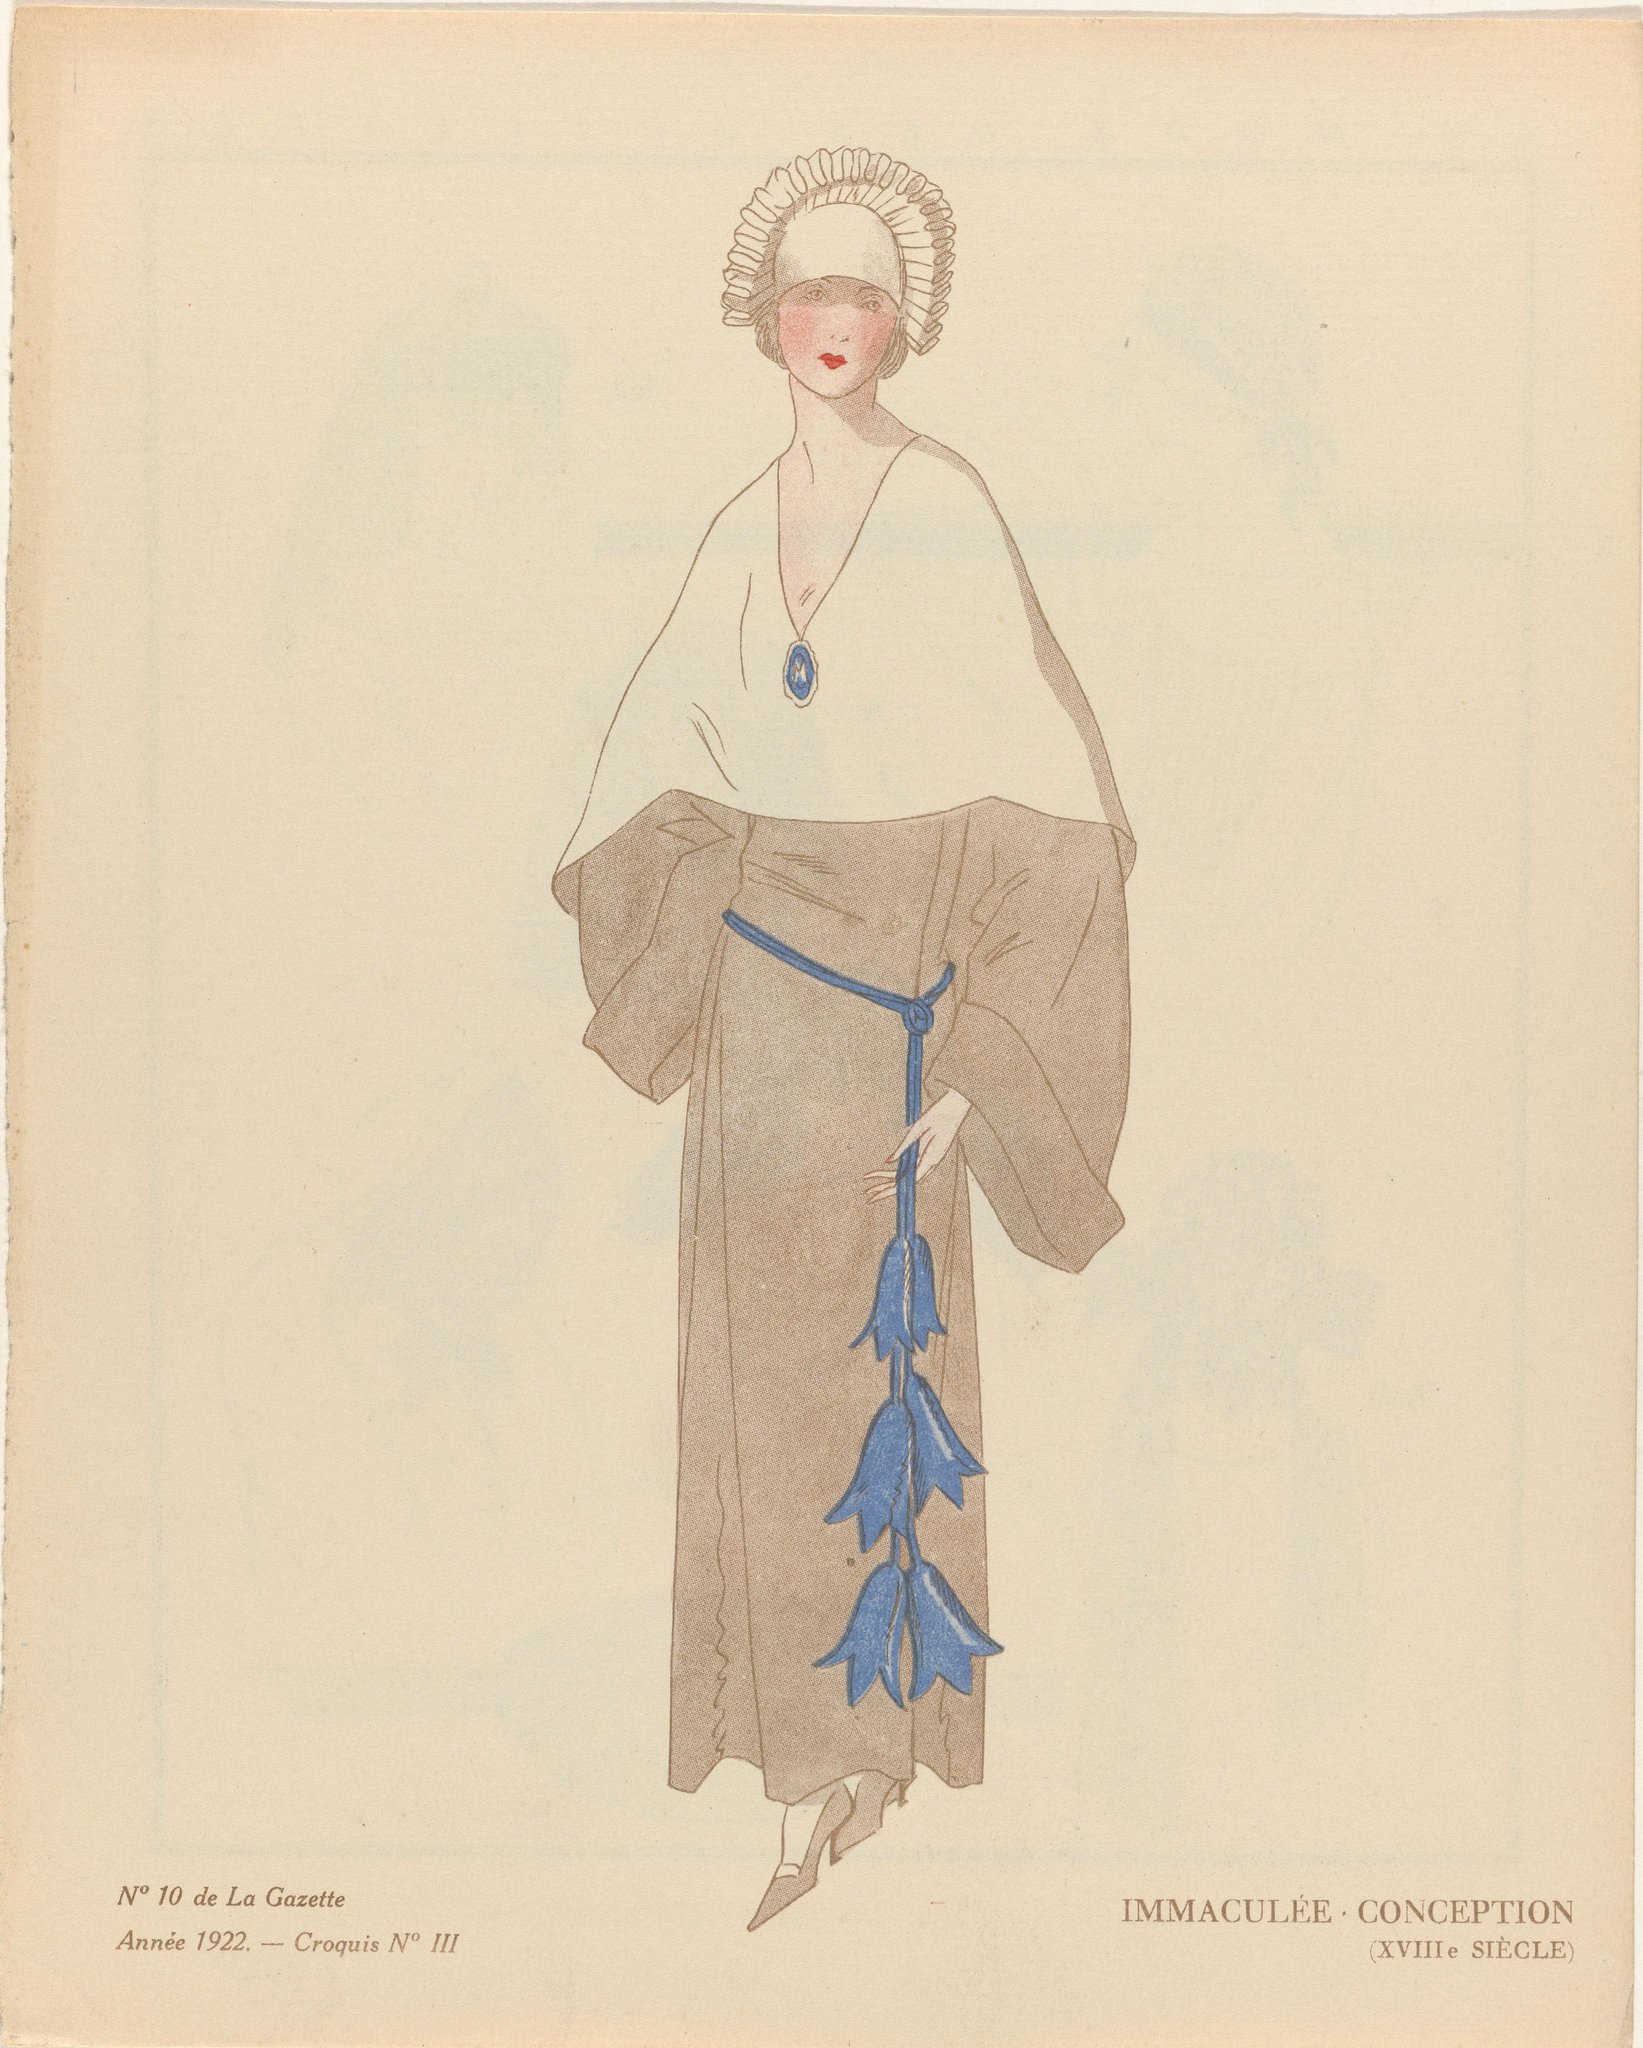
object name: fashion print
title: Accessories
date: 1922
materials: paper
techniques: printing, letterpress printing, photochemical processes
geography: new york city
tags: head-gear (+ women's clothes), fashion plates, dress, gown (+ women's clothes), belt, girdle, waistband (+ women's clothes)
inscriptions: date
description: Fans, parasols, opera gloves, fashionable hats, small toques garnished with feathers, wristwatches, compact bracelets, and luxuriously crafted lighters: there was a dazzling variety of accessories in the 1920s. Small bags could be suspended from a belt, or a glove. Walking sticks and the shafts of umbrellas and parasols were often embellished with carving clearly inspired by African and Indian art. And Russian influence was evident when it came to combs made of mother-of-pearl and ivory.